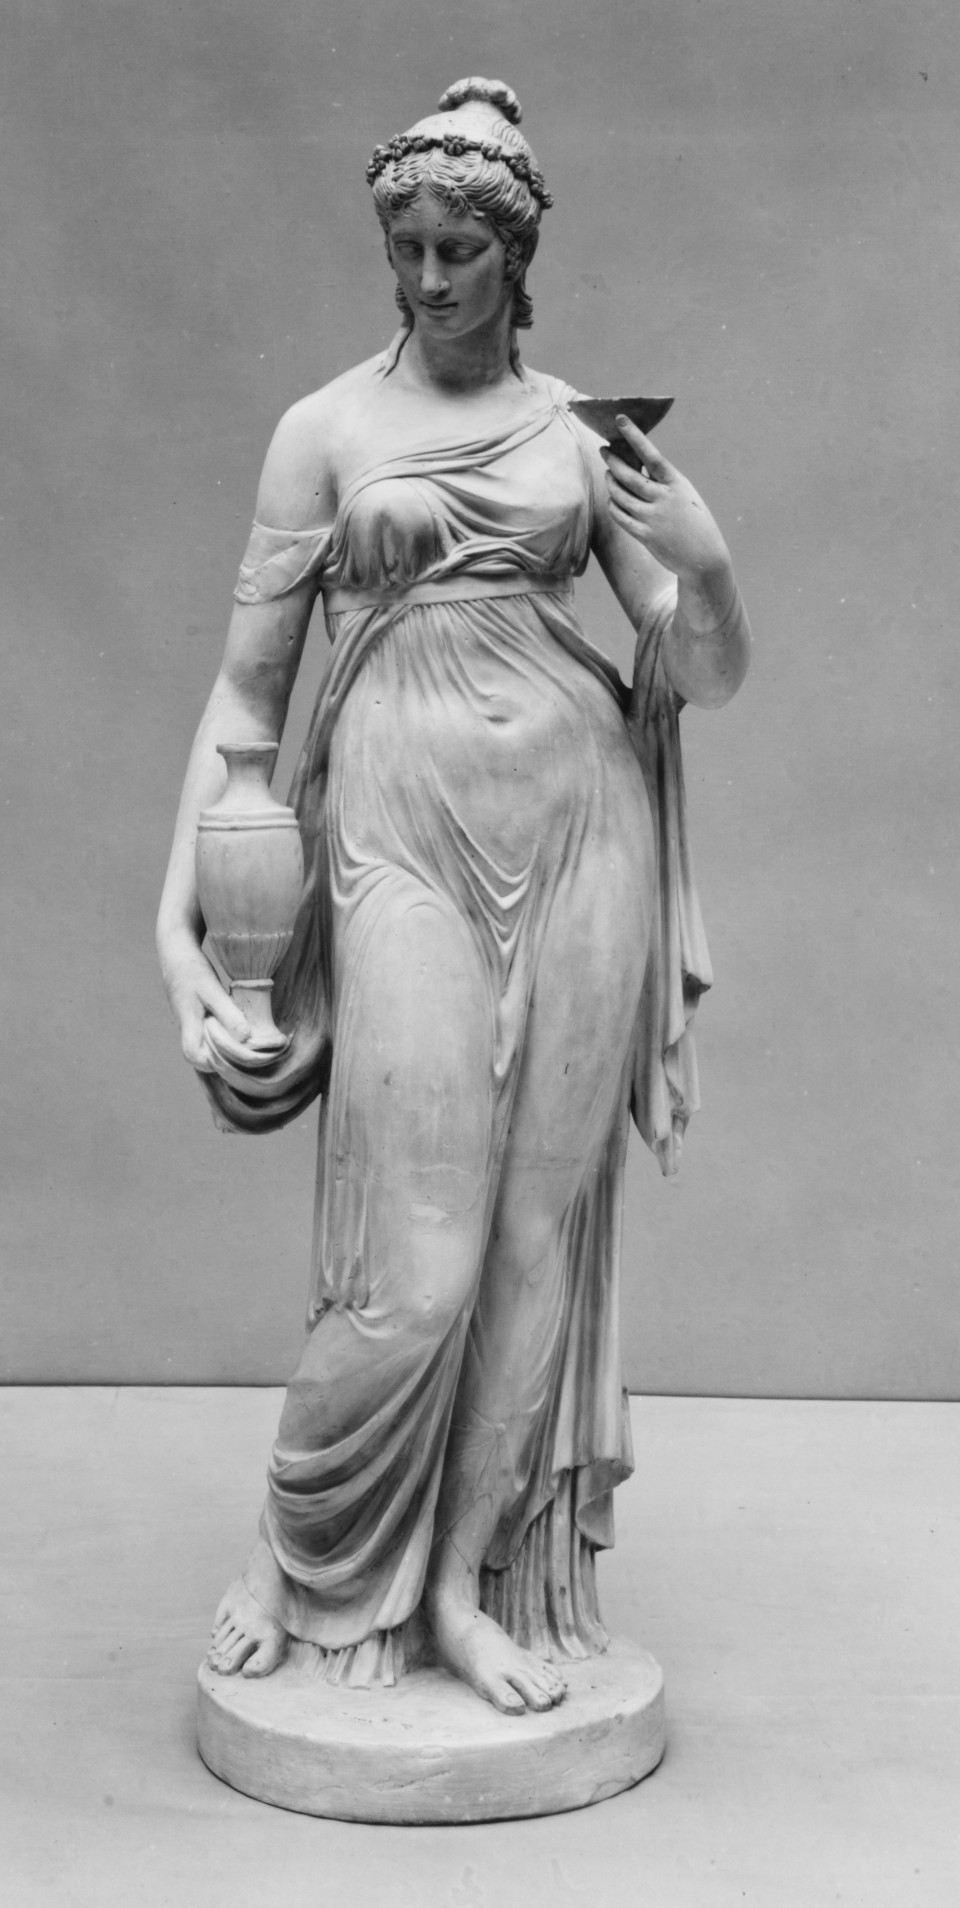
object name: statue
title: Nymph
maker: polly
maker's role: artist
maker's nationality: french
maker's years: 1795-1805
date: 1805-1810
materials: plaster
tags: nymphs